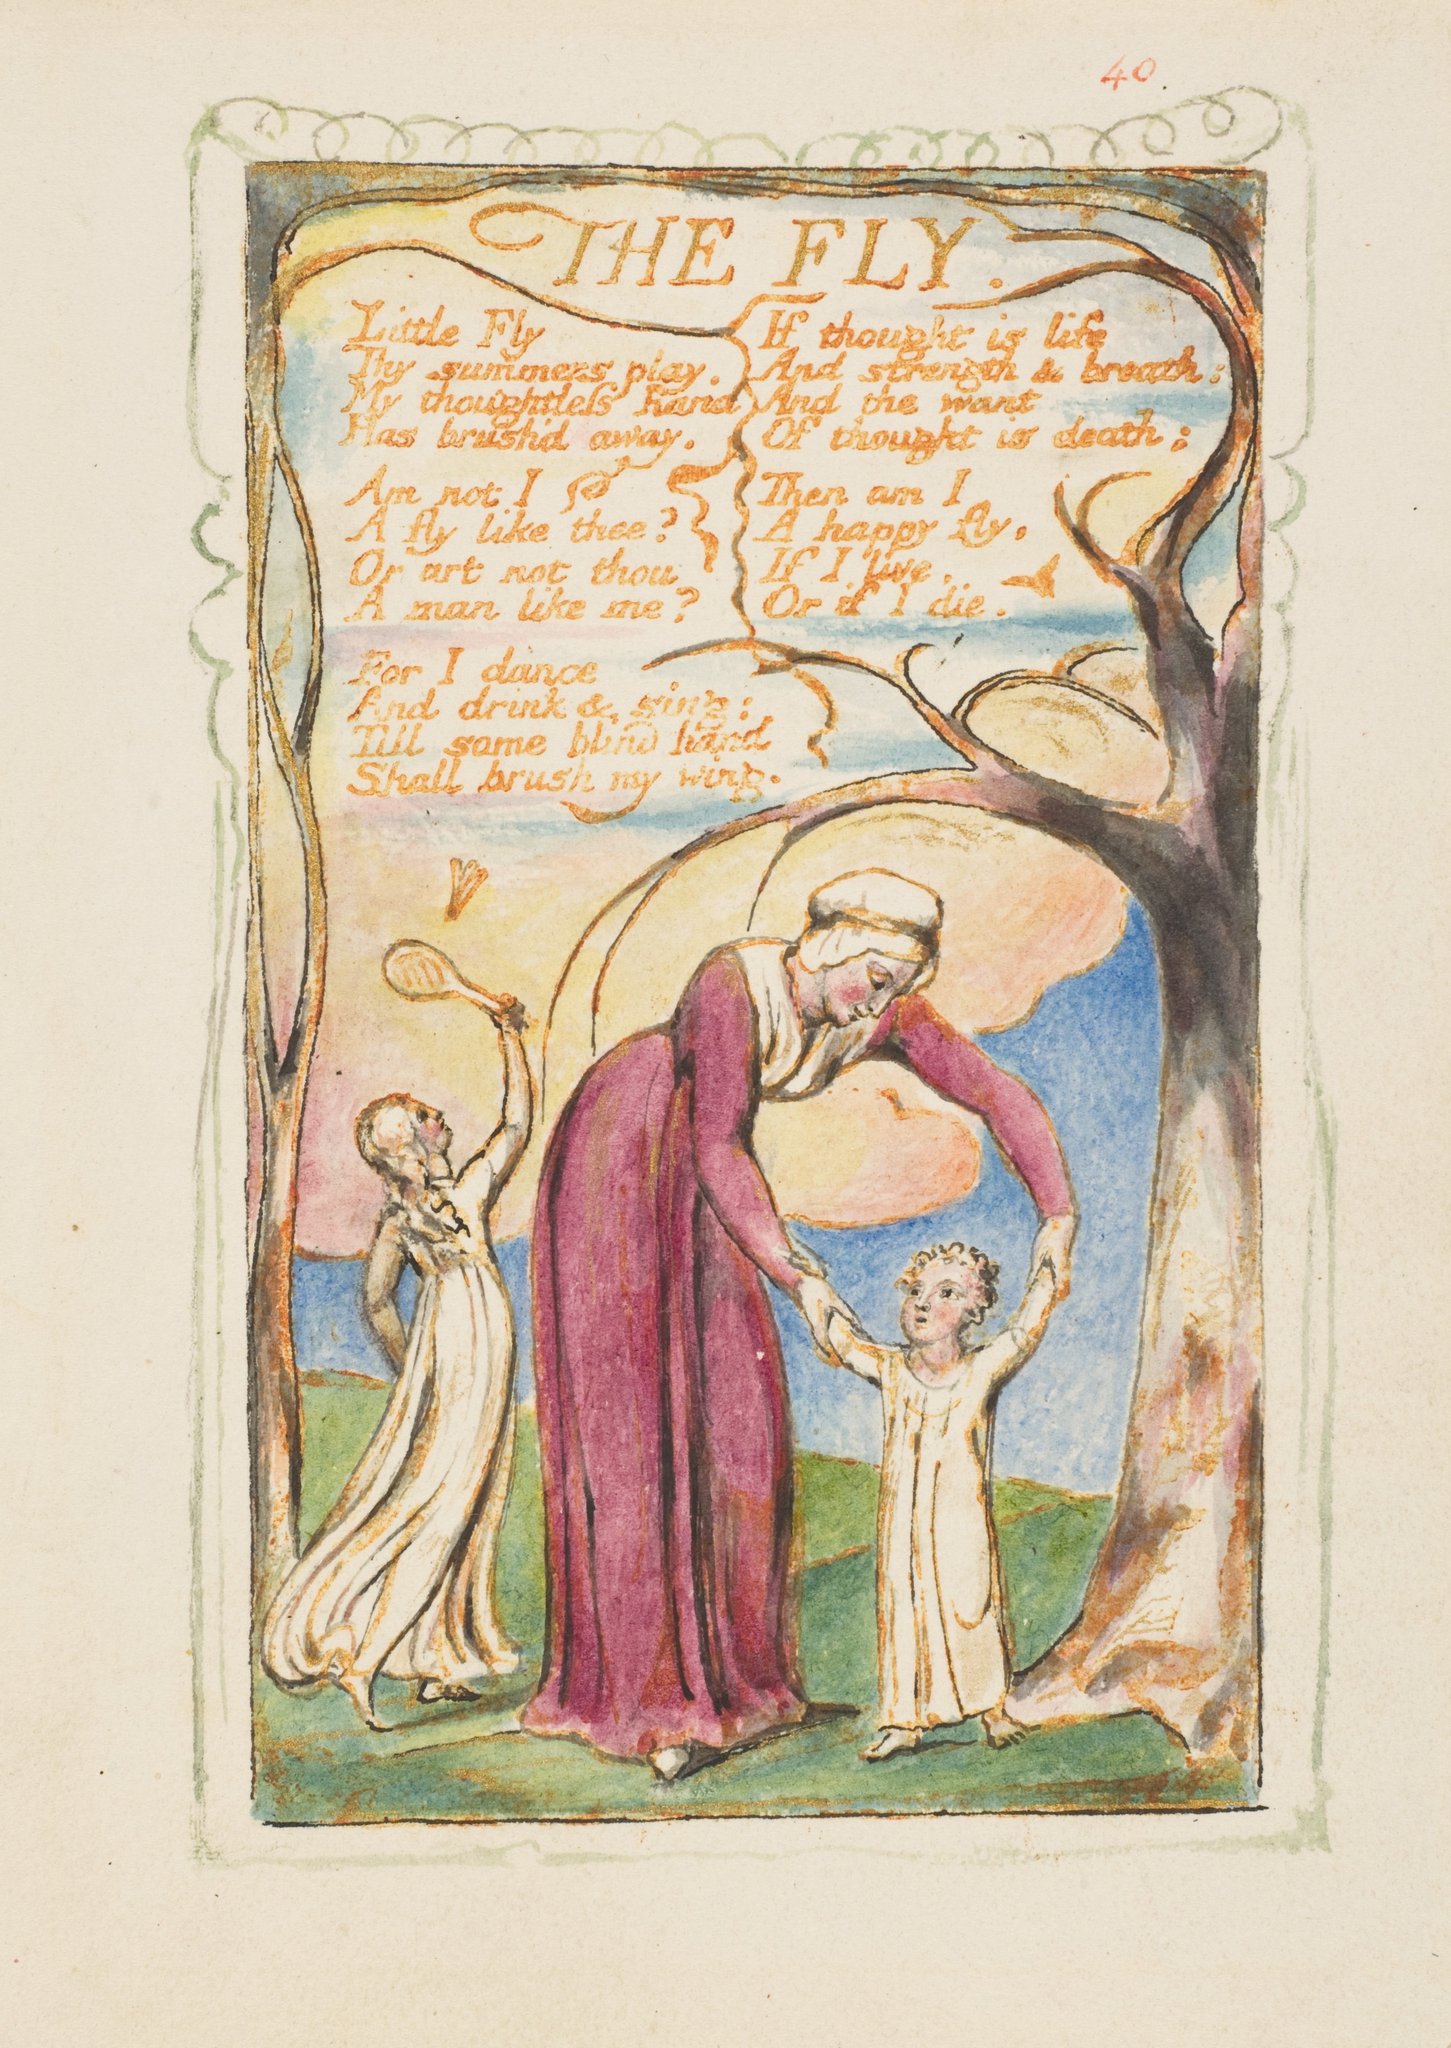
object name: print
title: Songs of Experience: The Fly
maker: william blake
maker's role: artist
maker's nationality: british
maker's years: 1757-1827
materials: gold, ink, shell, watercolor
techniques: etching, hand coloring, printing, relief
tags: poetry,children,women,sports